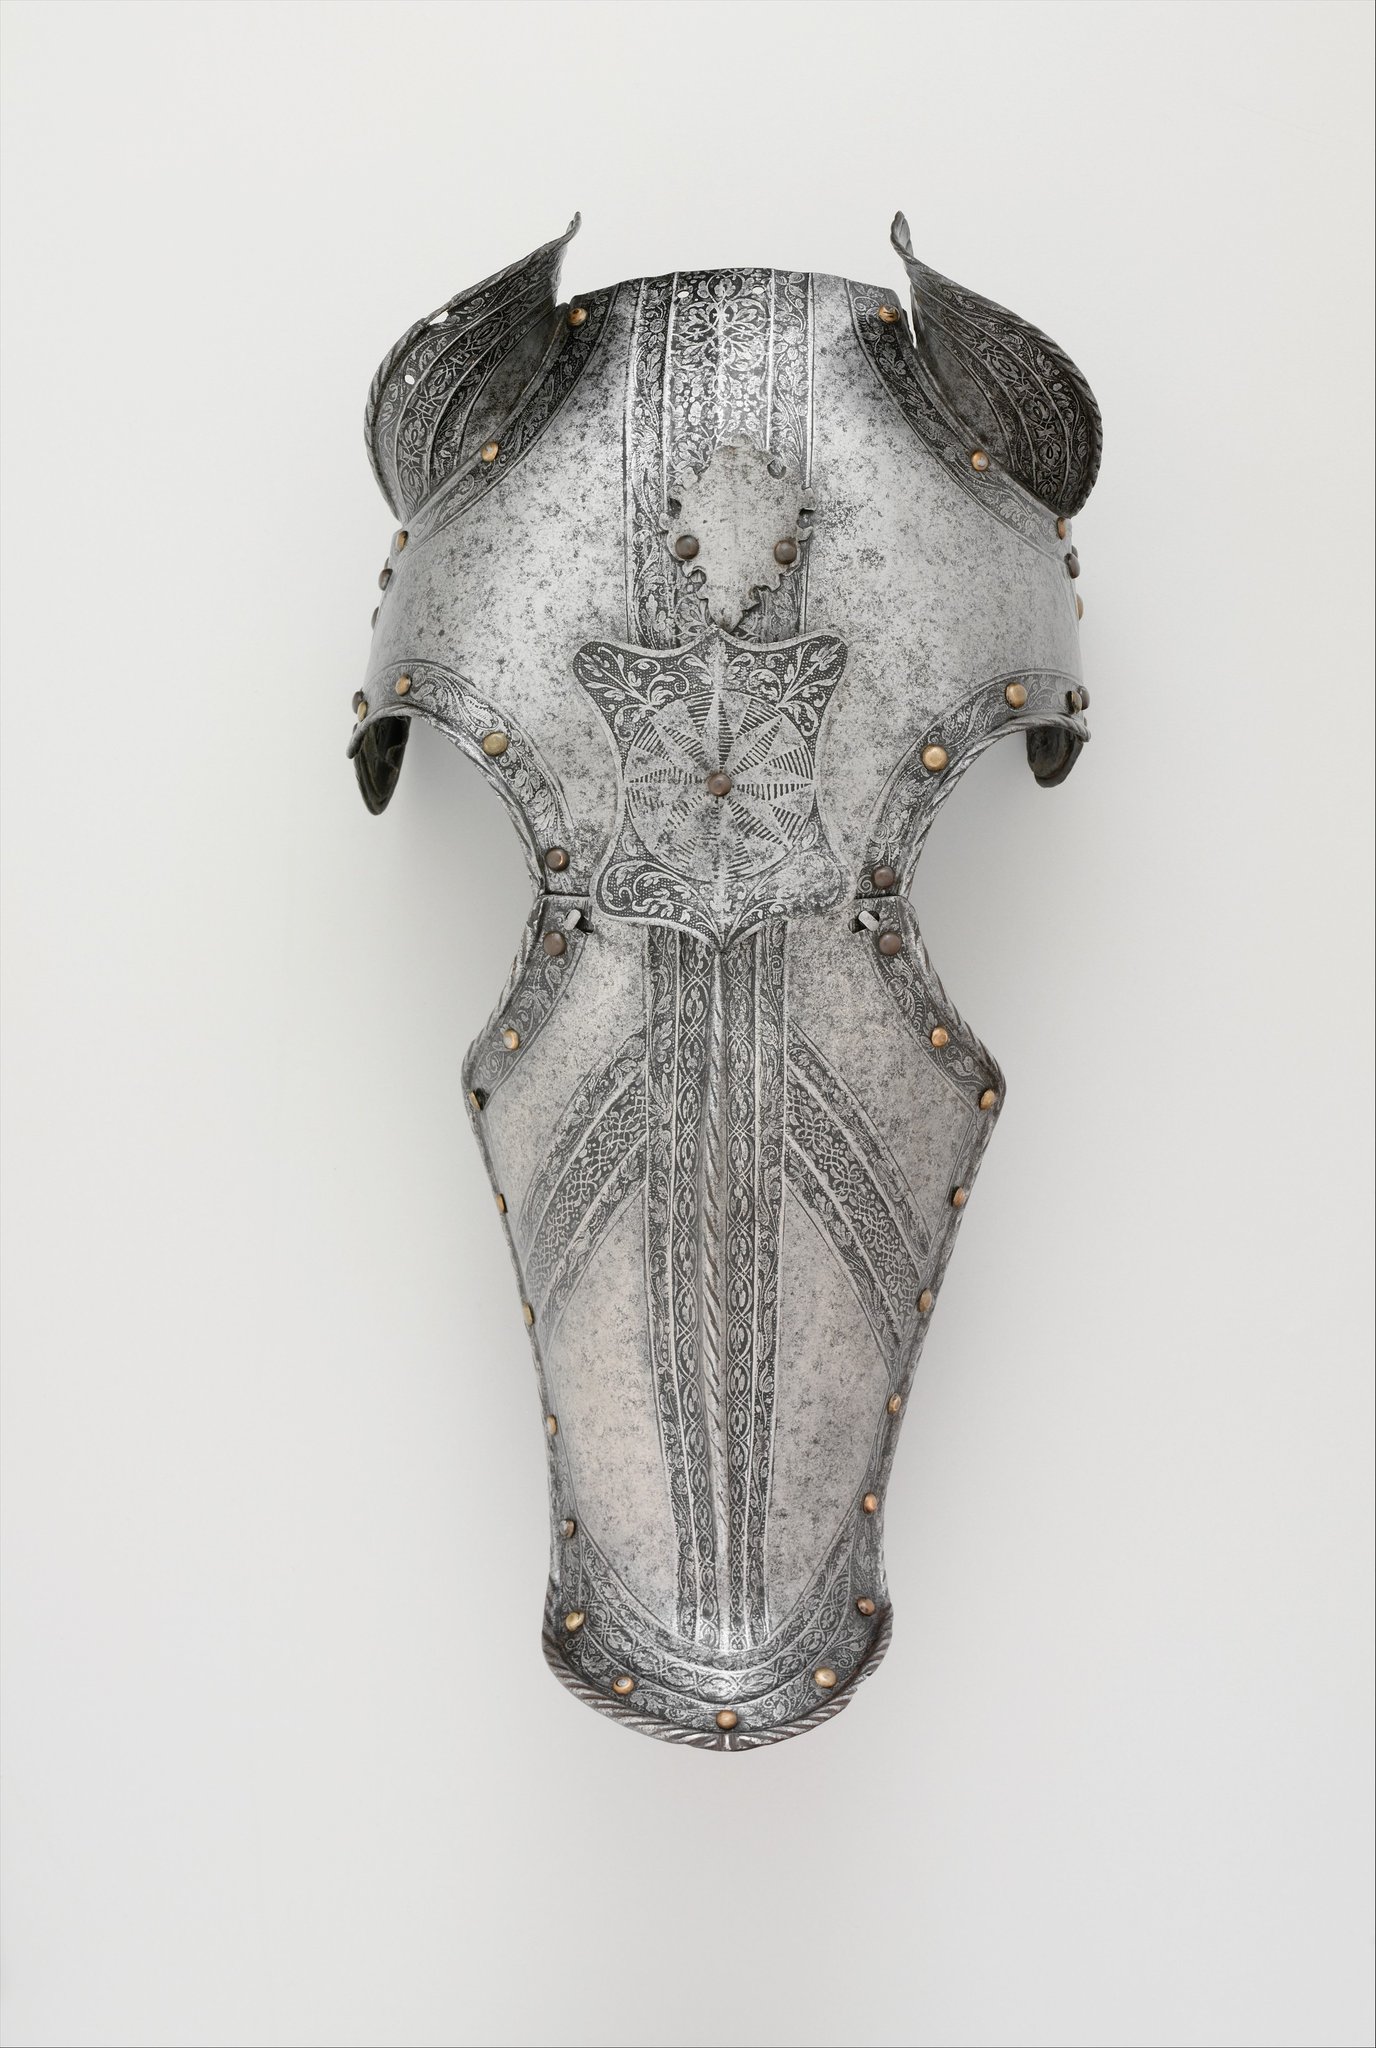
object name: shaffron horse's head defense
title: Shaffron (Horse's Head Defense)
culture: german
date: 1545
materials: brass, leather, steel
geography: germany